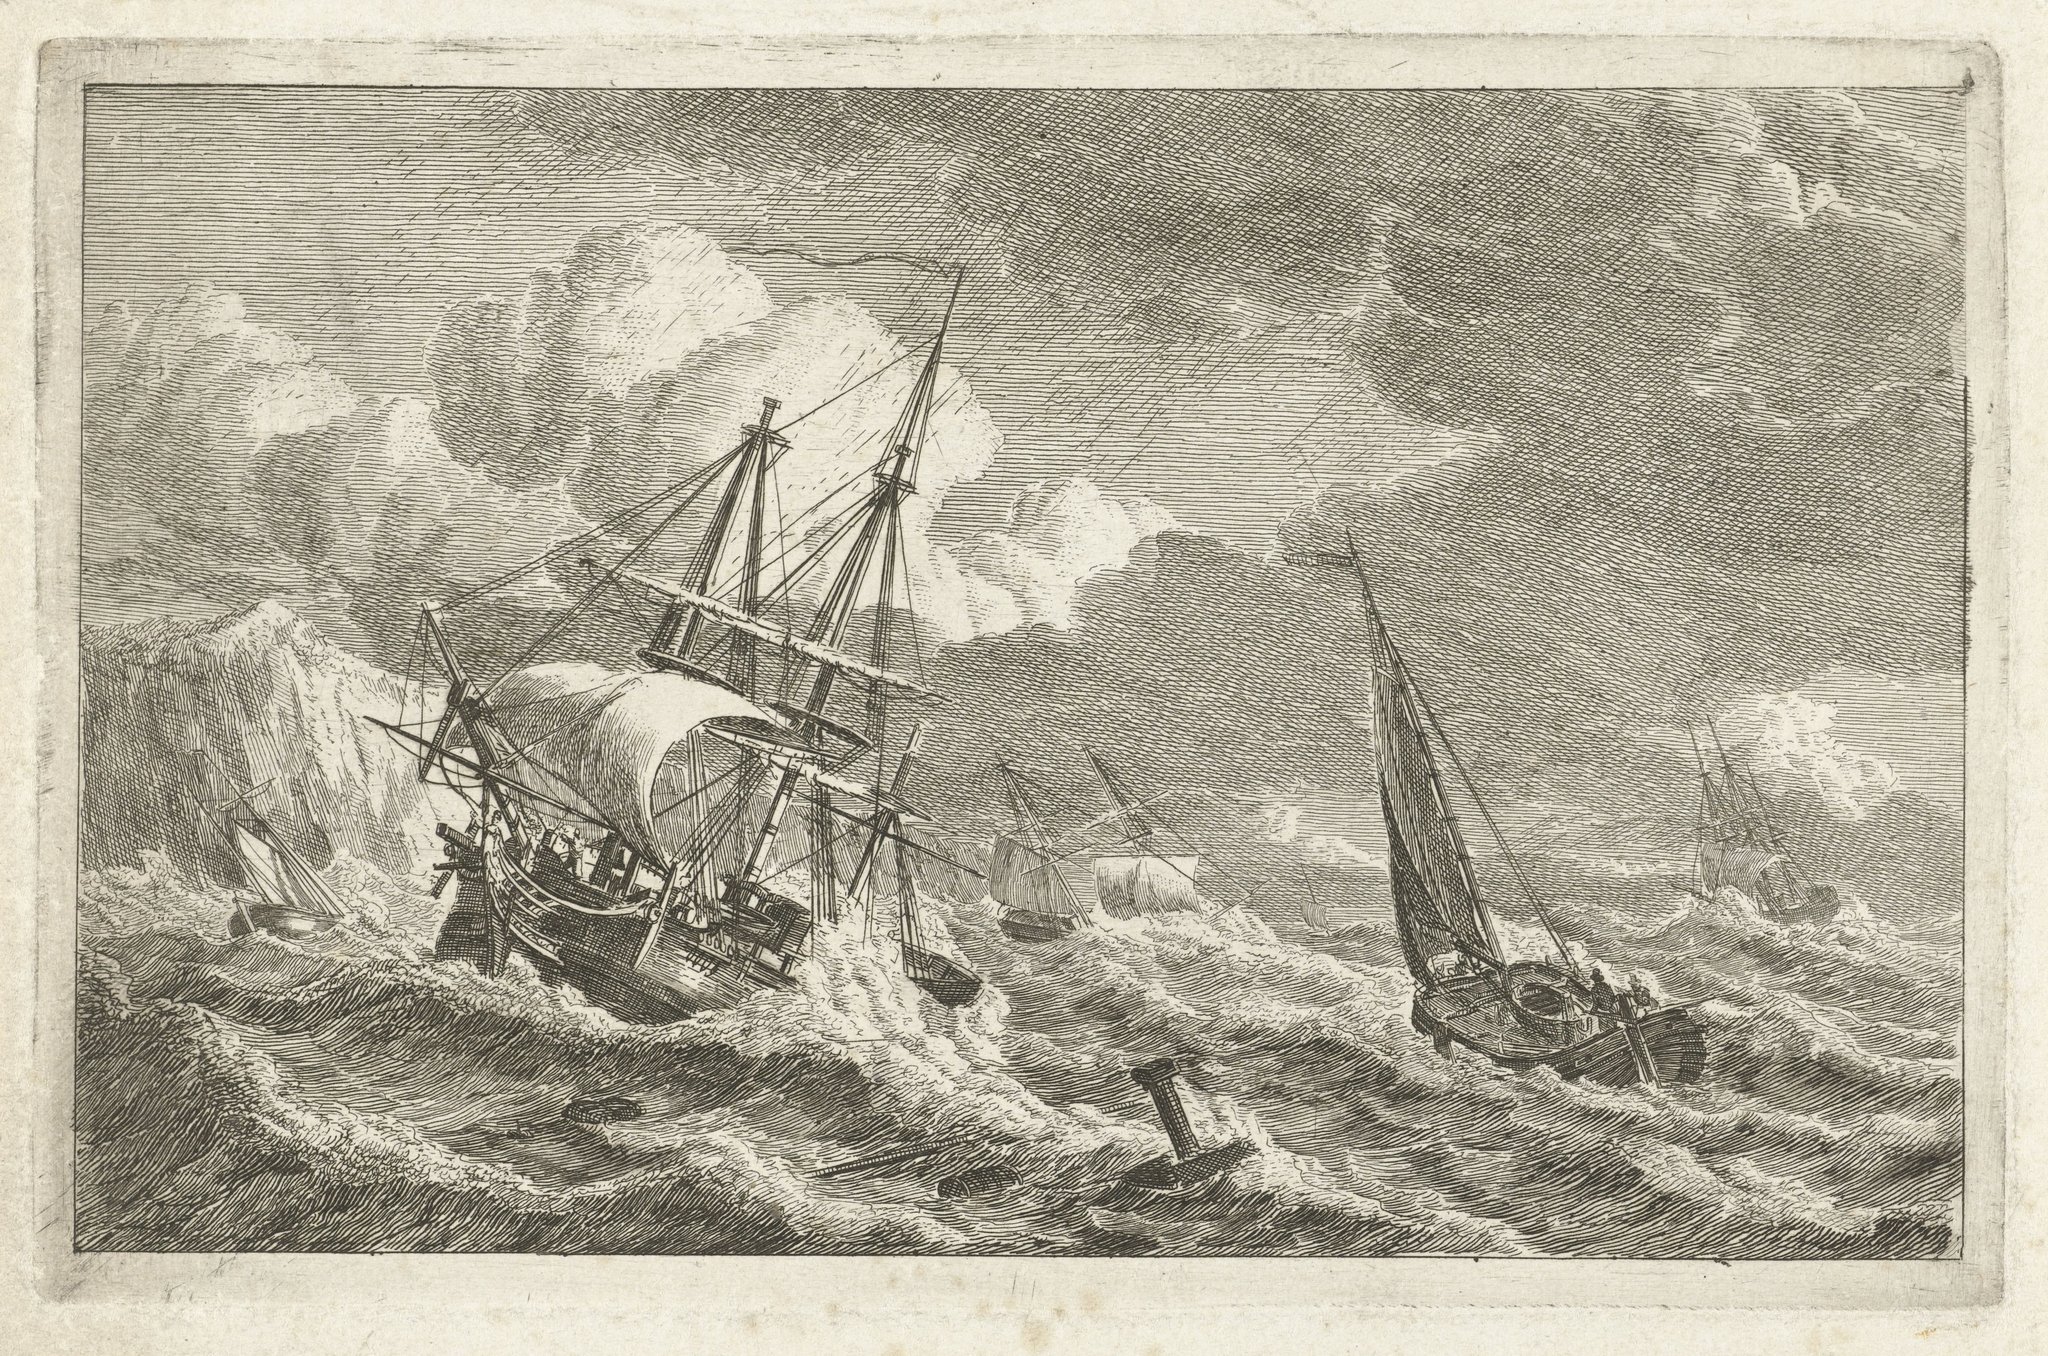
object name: print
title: Schepen in nood bij een rotsachtige kust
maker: gerrit groenewegen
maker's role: draughtsman, print maker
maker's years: 1754-1826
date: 1807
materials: paper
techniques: etching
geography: rotterdam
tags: ships (in general) - cc - more than one ship, storm at sea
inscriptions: collector's mark: Lugt 2228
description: Storm op zee. Links een driemaster die op het punt staat om tegen de rotsen te slaan. Rechts een visschersschuit, waarin twee personen aan het roer staan. Deze prent maakt deel uit van een serie van zes prenten met diverse schepen.